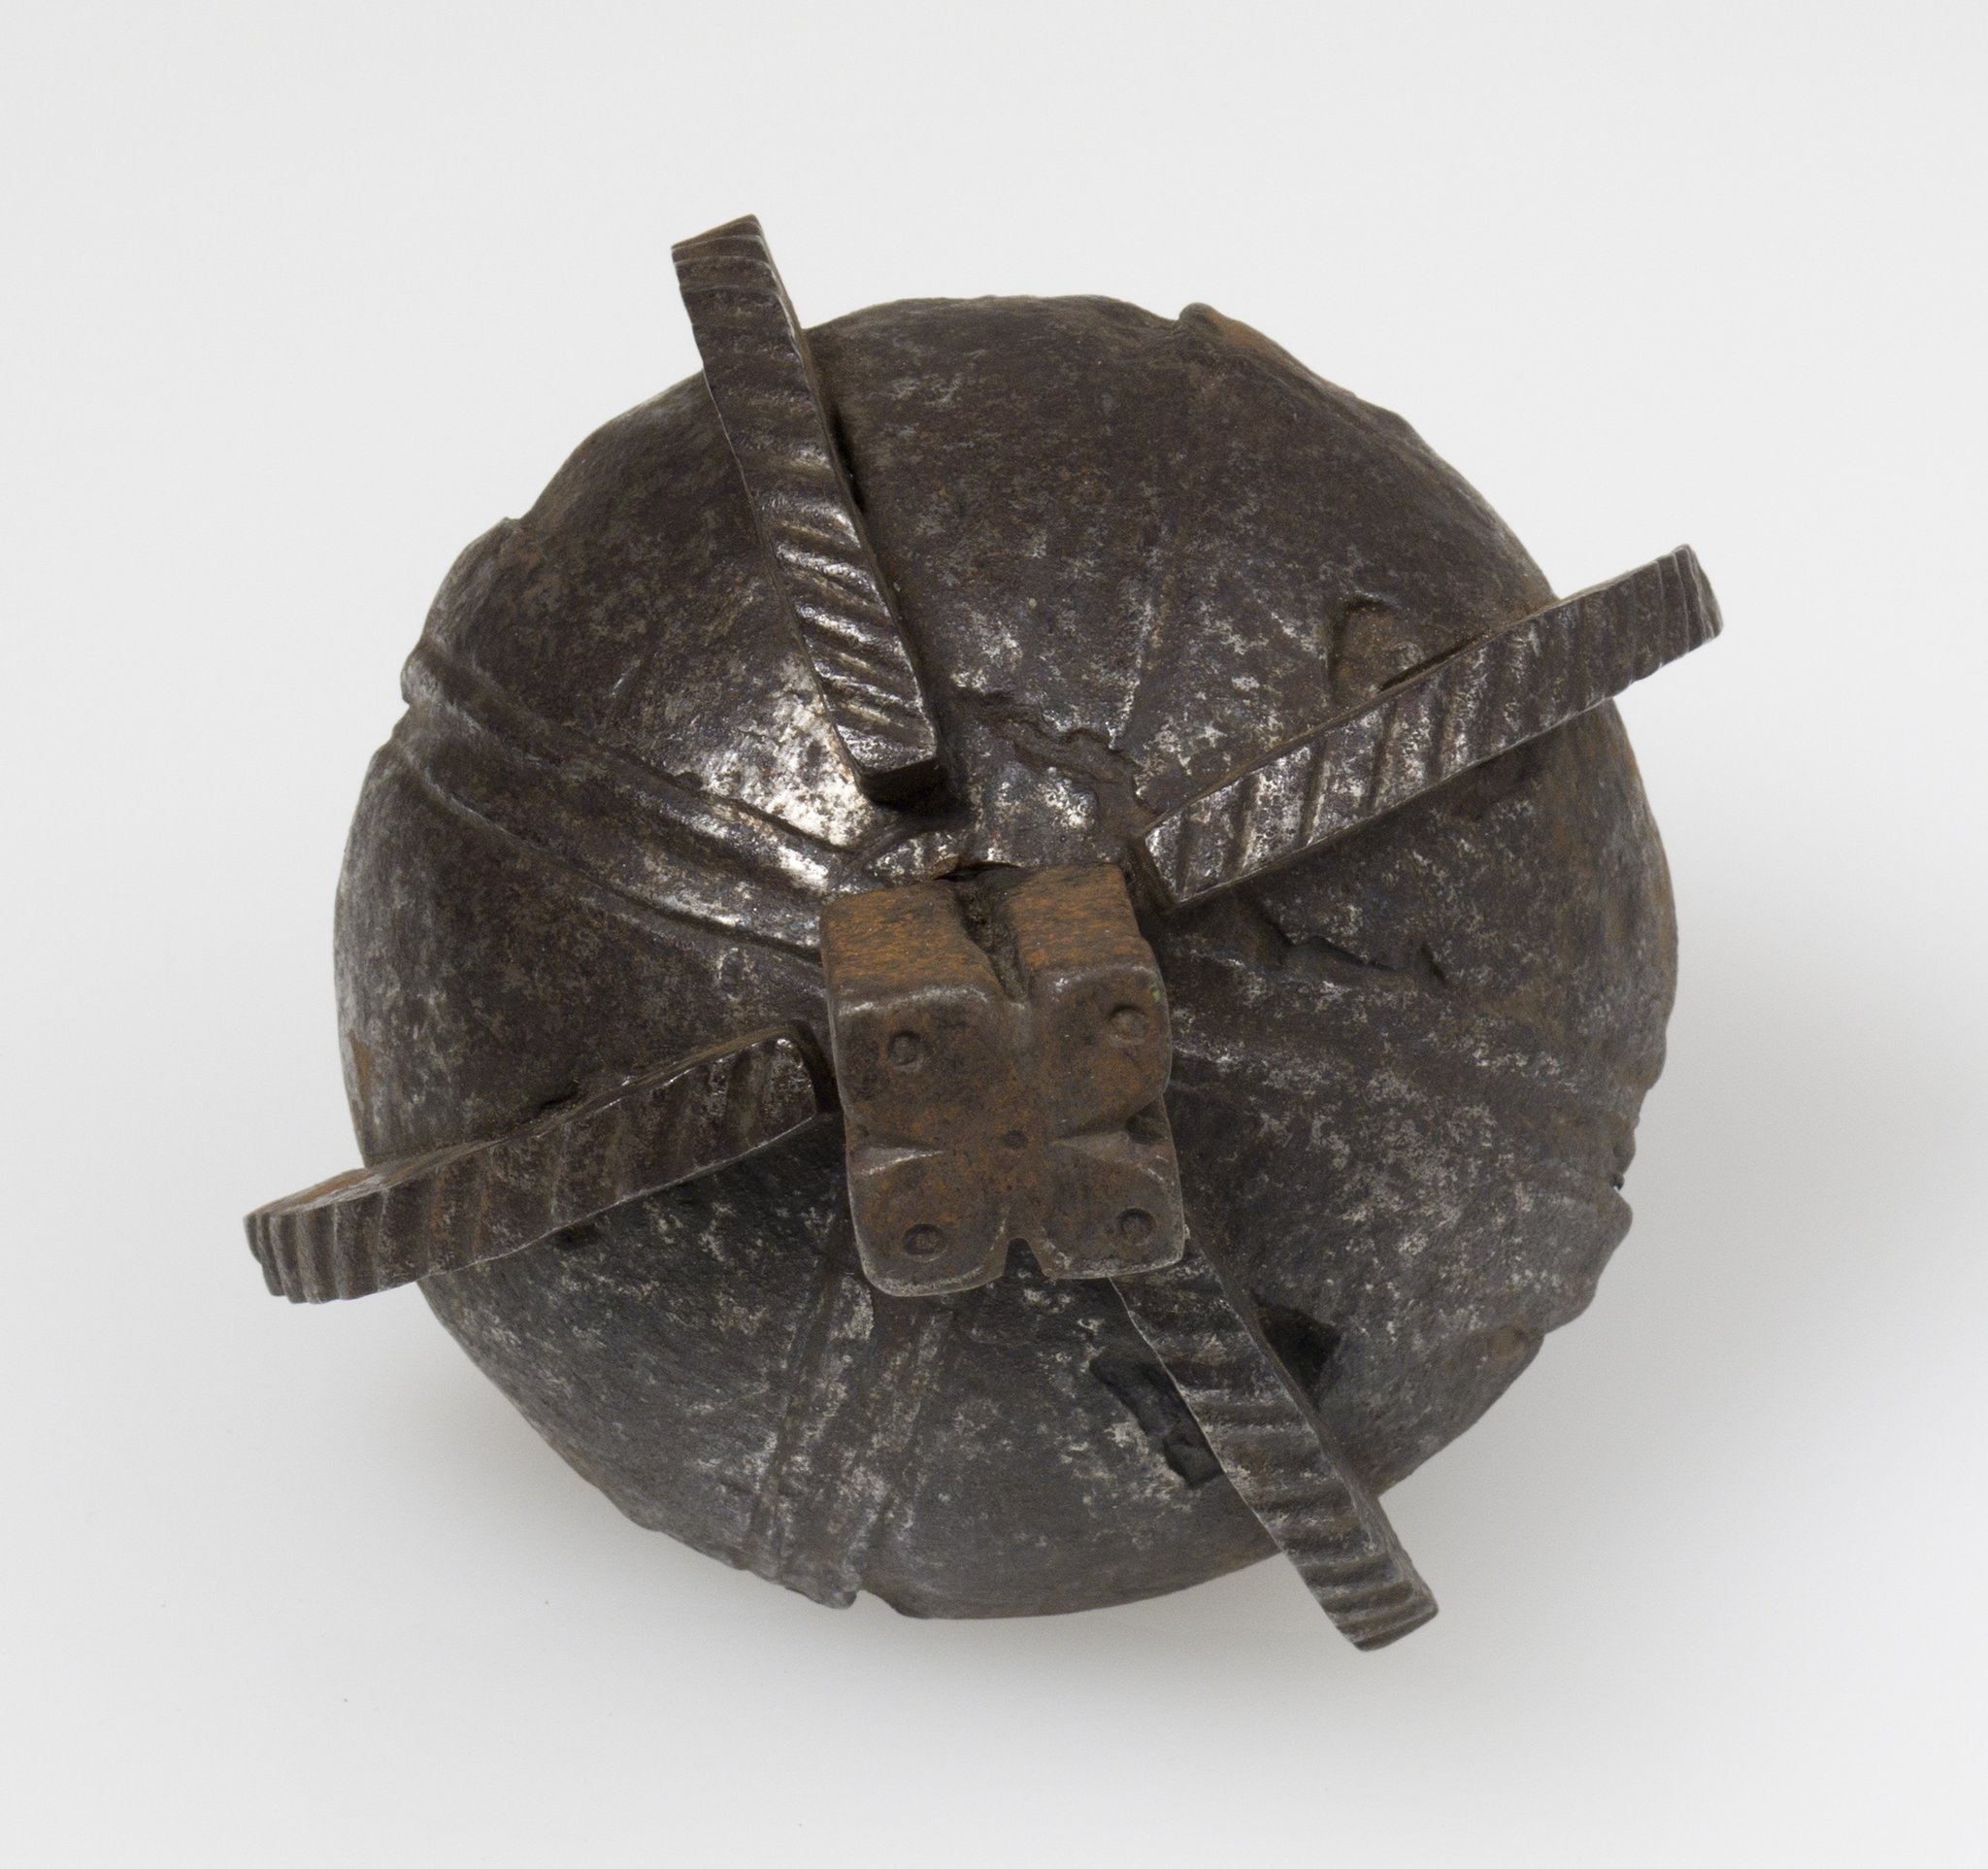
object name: bos and nail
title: Boss and Nail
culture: european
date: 1401-1600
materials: iron